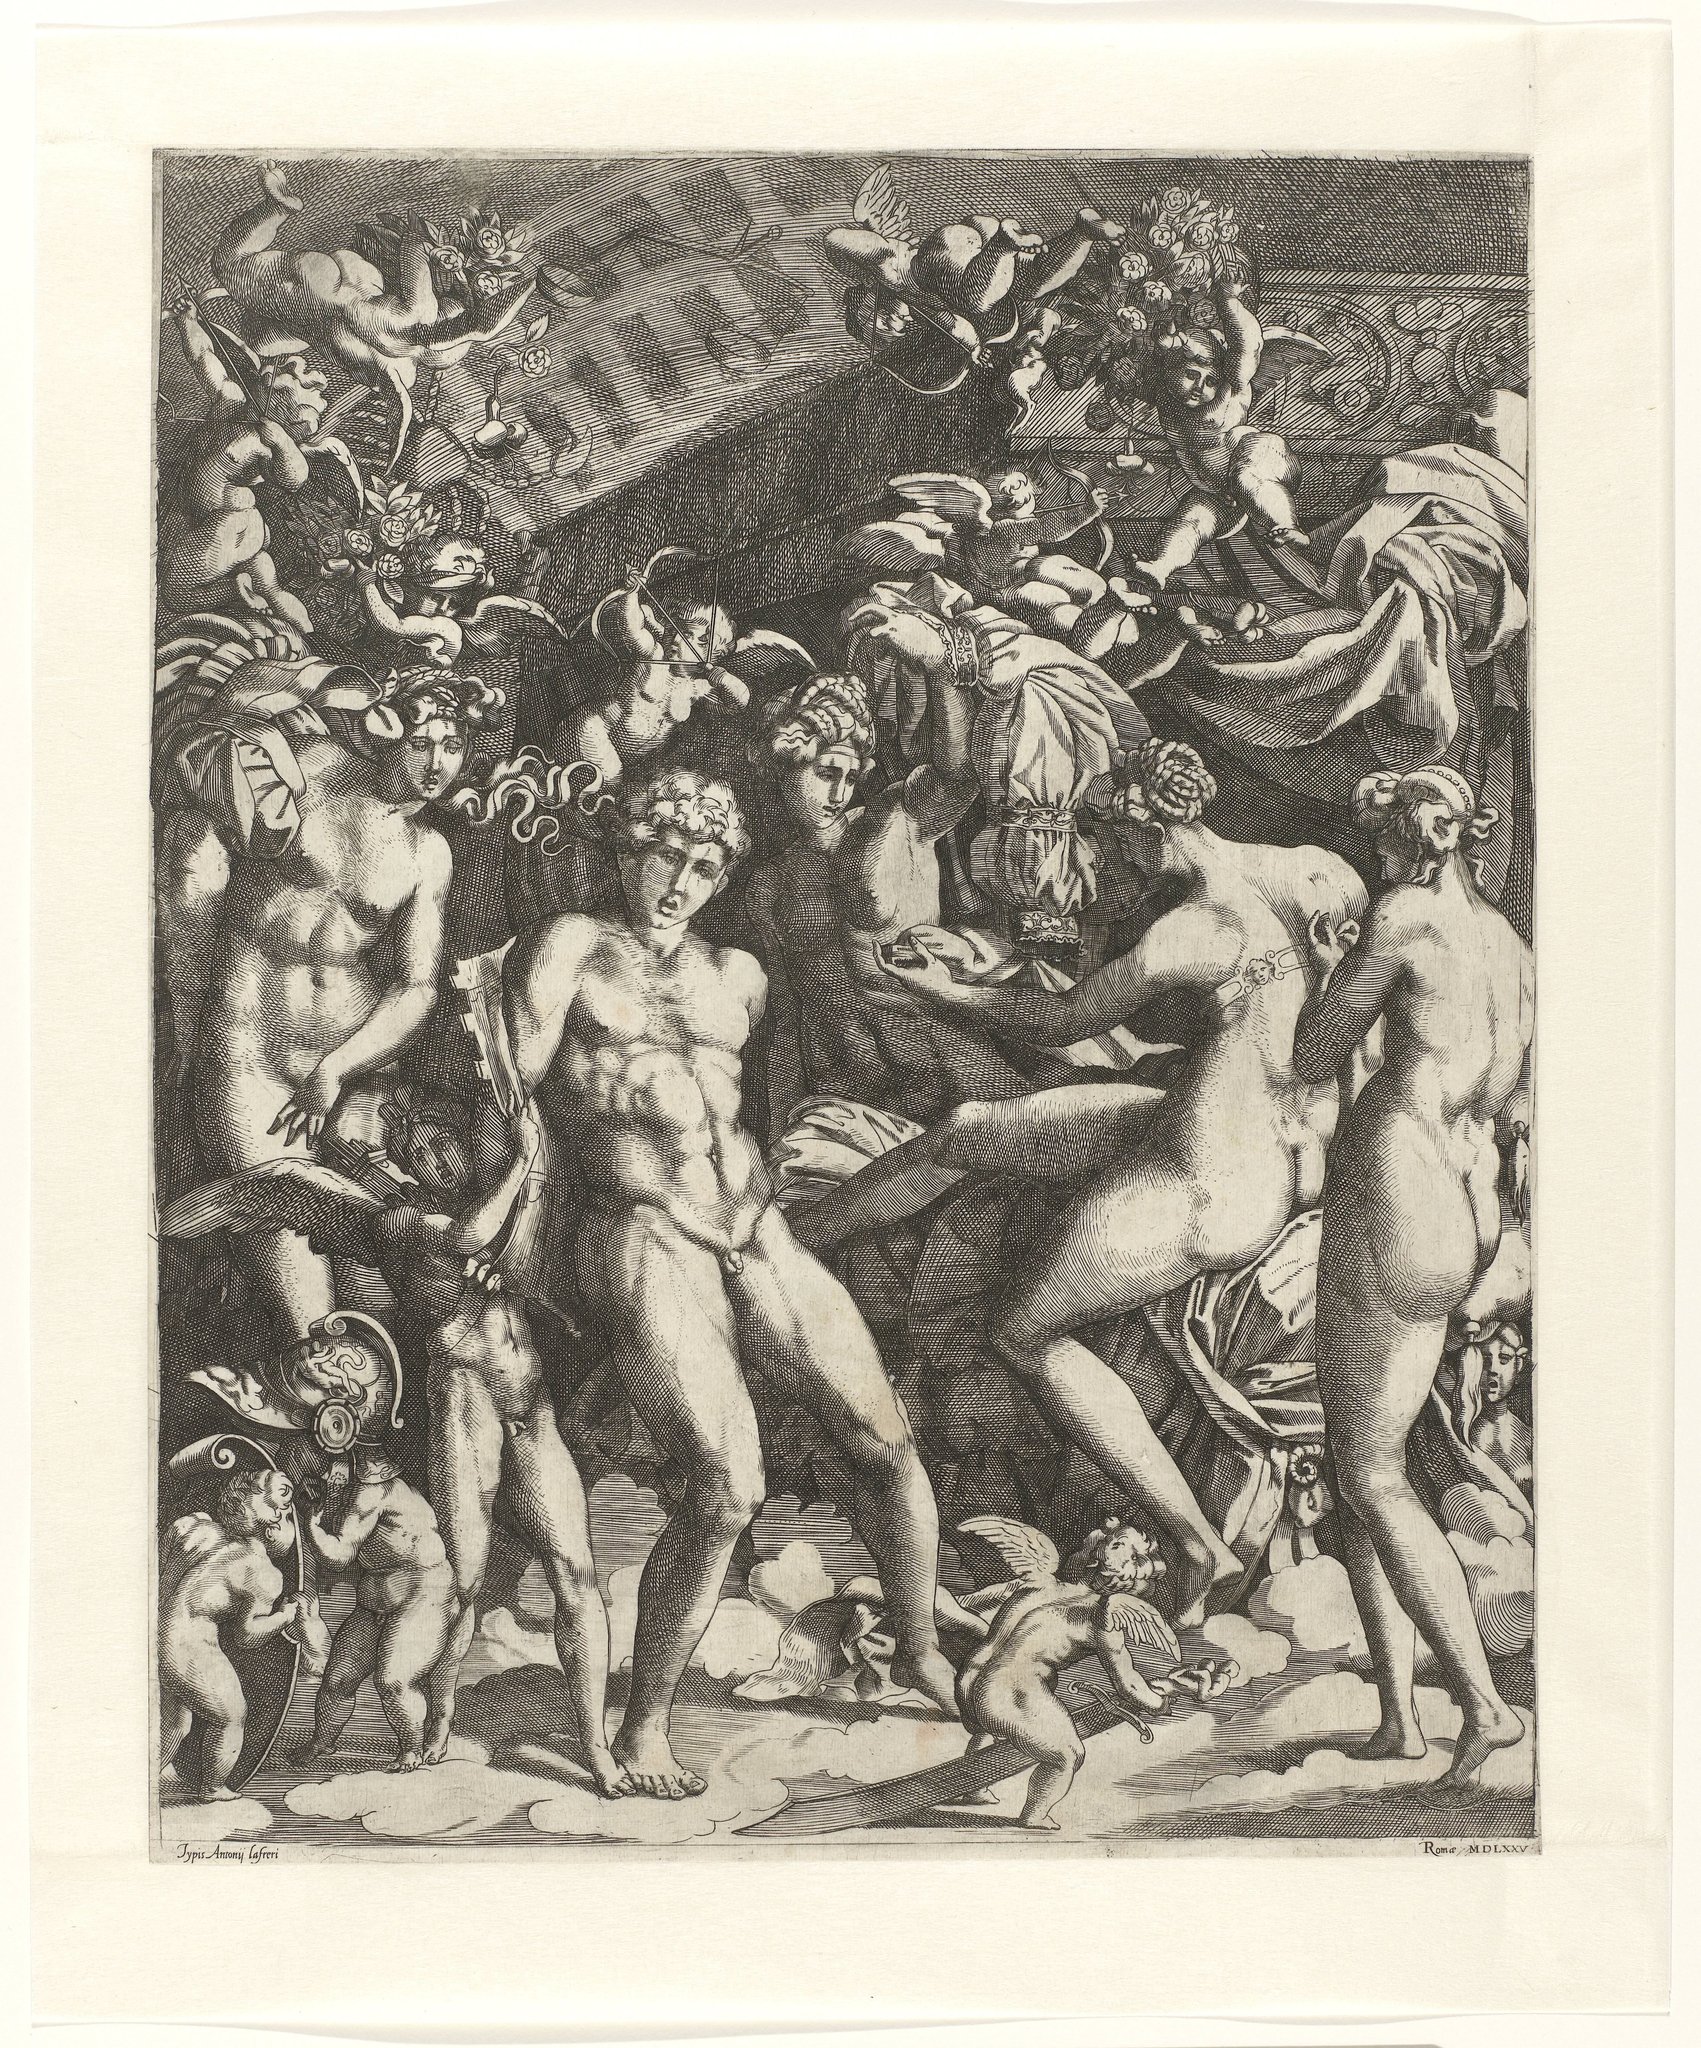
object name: print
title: Mars en Venus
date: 1575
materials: paper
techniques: engraving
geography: italy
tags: mars and venus as lovers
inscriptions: collector's mark: Lugt 2228, collector's mark: Lugt 2760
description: Mars wordt door verschillende putti ontdaan van zijn kleding. Twee putti spelen met de helm en het schild van de oorlogsgod. Rechts de naakte Venus op de rug gezien.